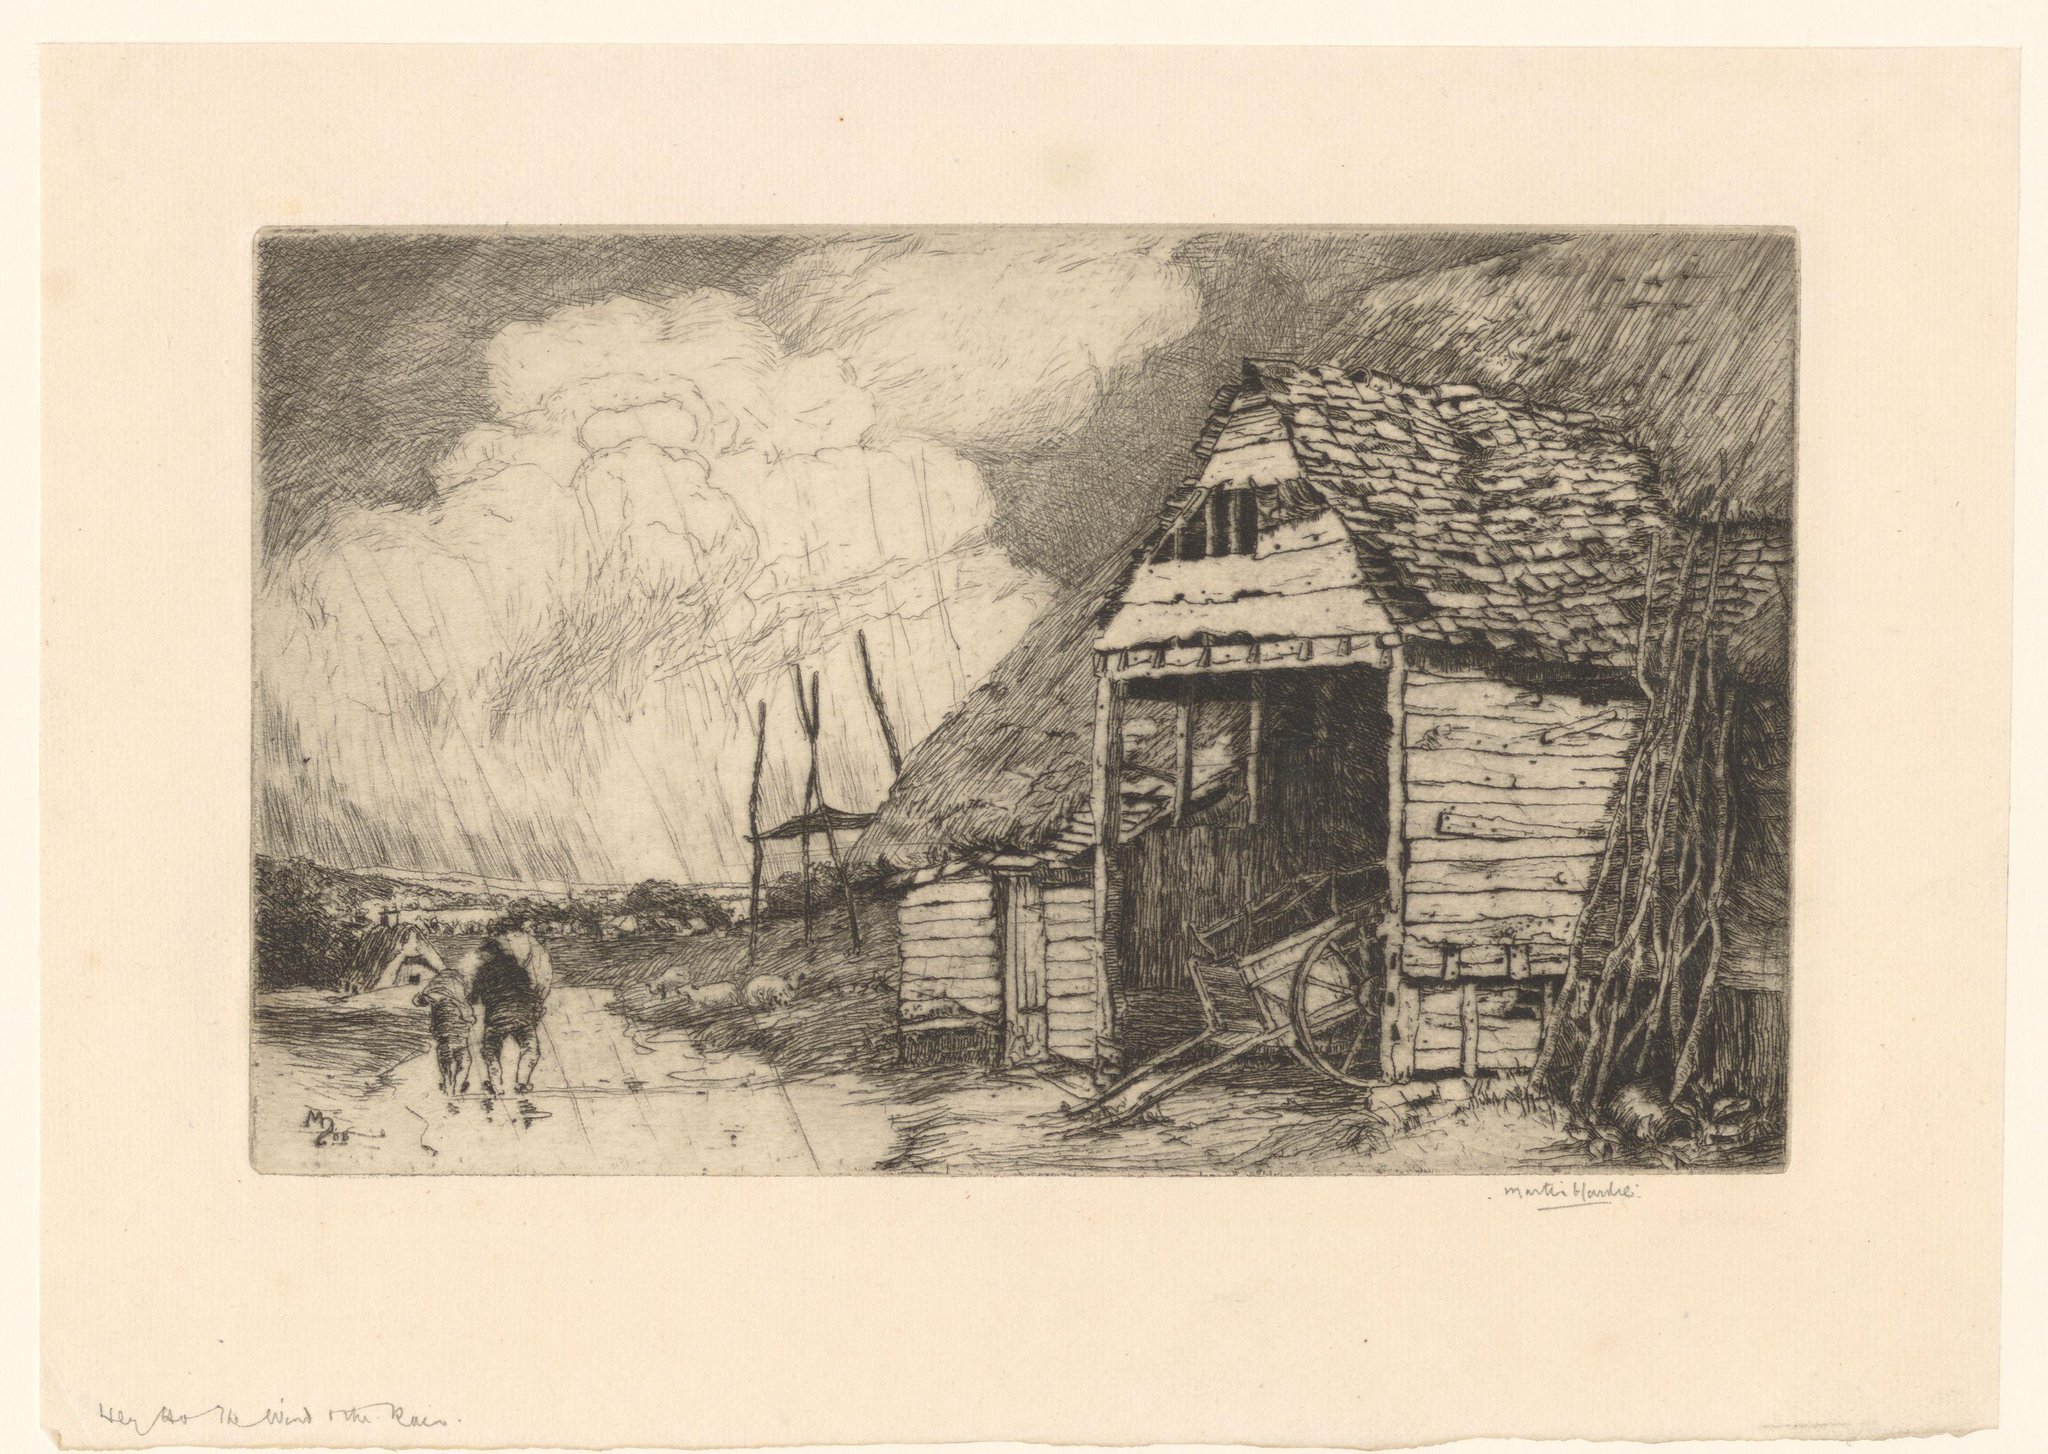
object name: print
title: Hey Ho! The Wind and the Rain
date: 1908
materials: paper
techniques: drypoint, etching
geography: brenchley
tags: barn, rain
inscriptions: collector's mark: Lugt 2760, collector's mark: Lugt 2228, annotation: ‘Martin Hardie’